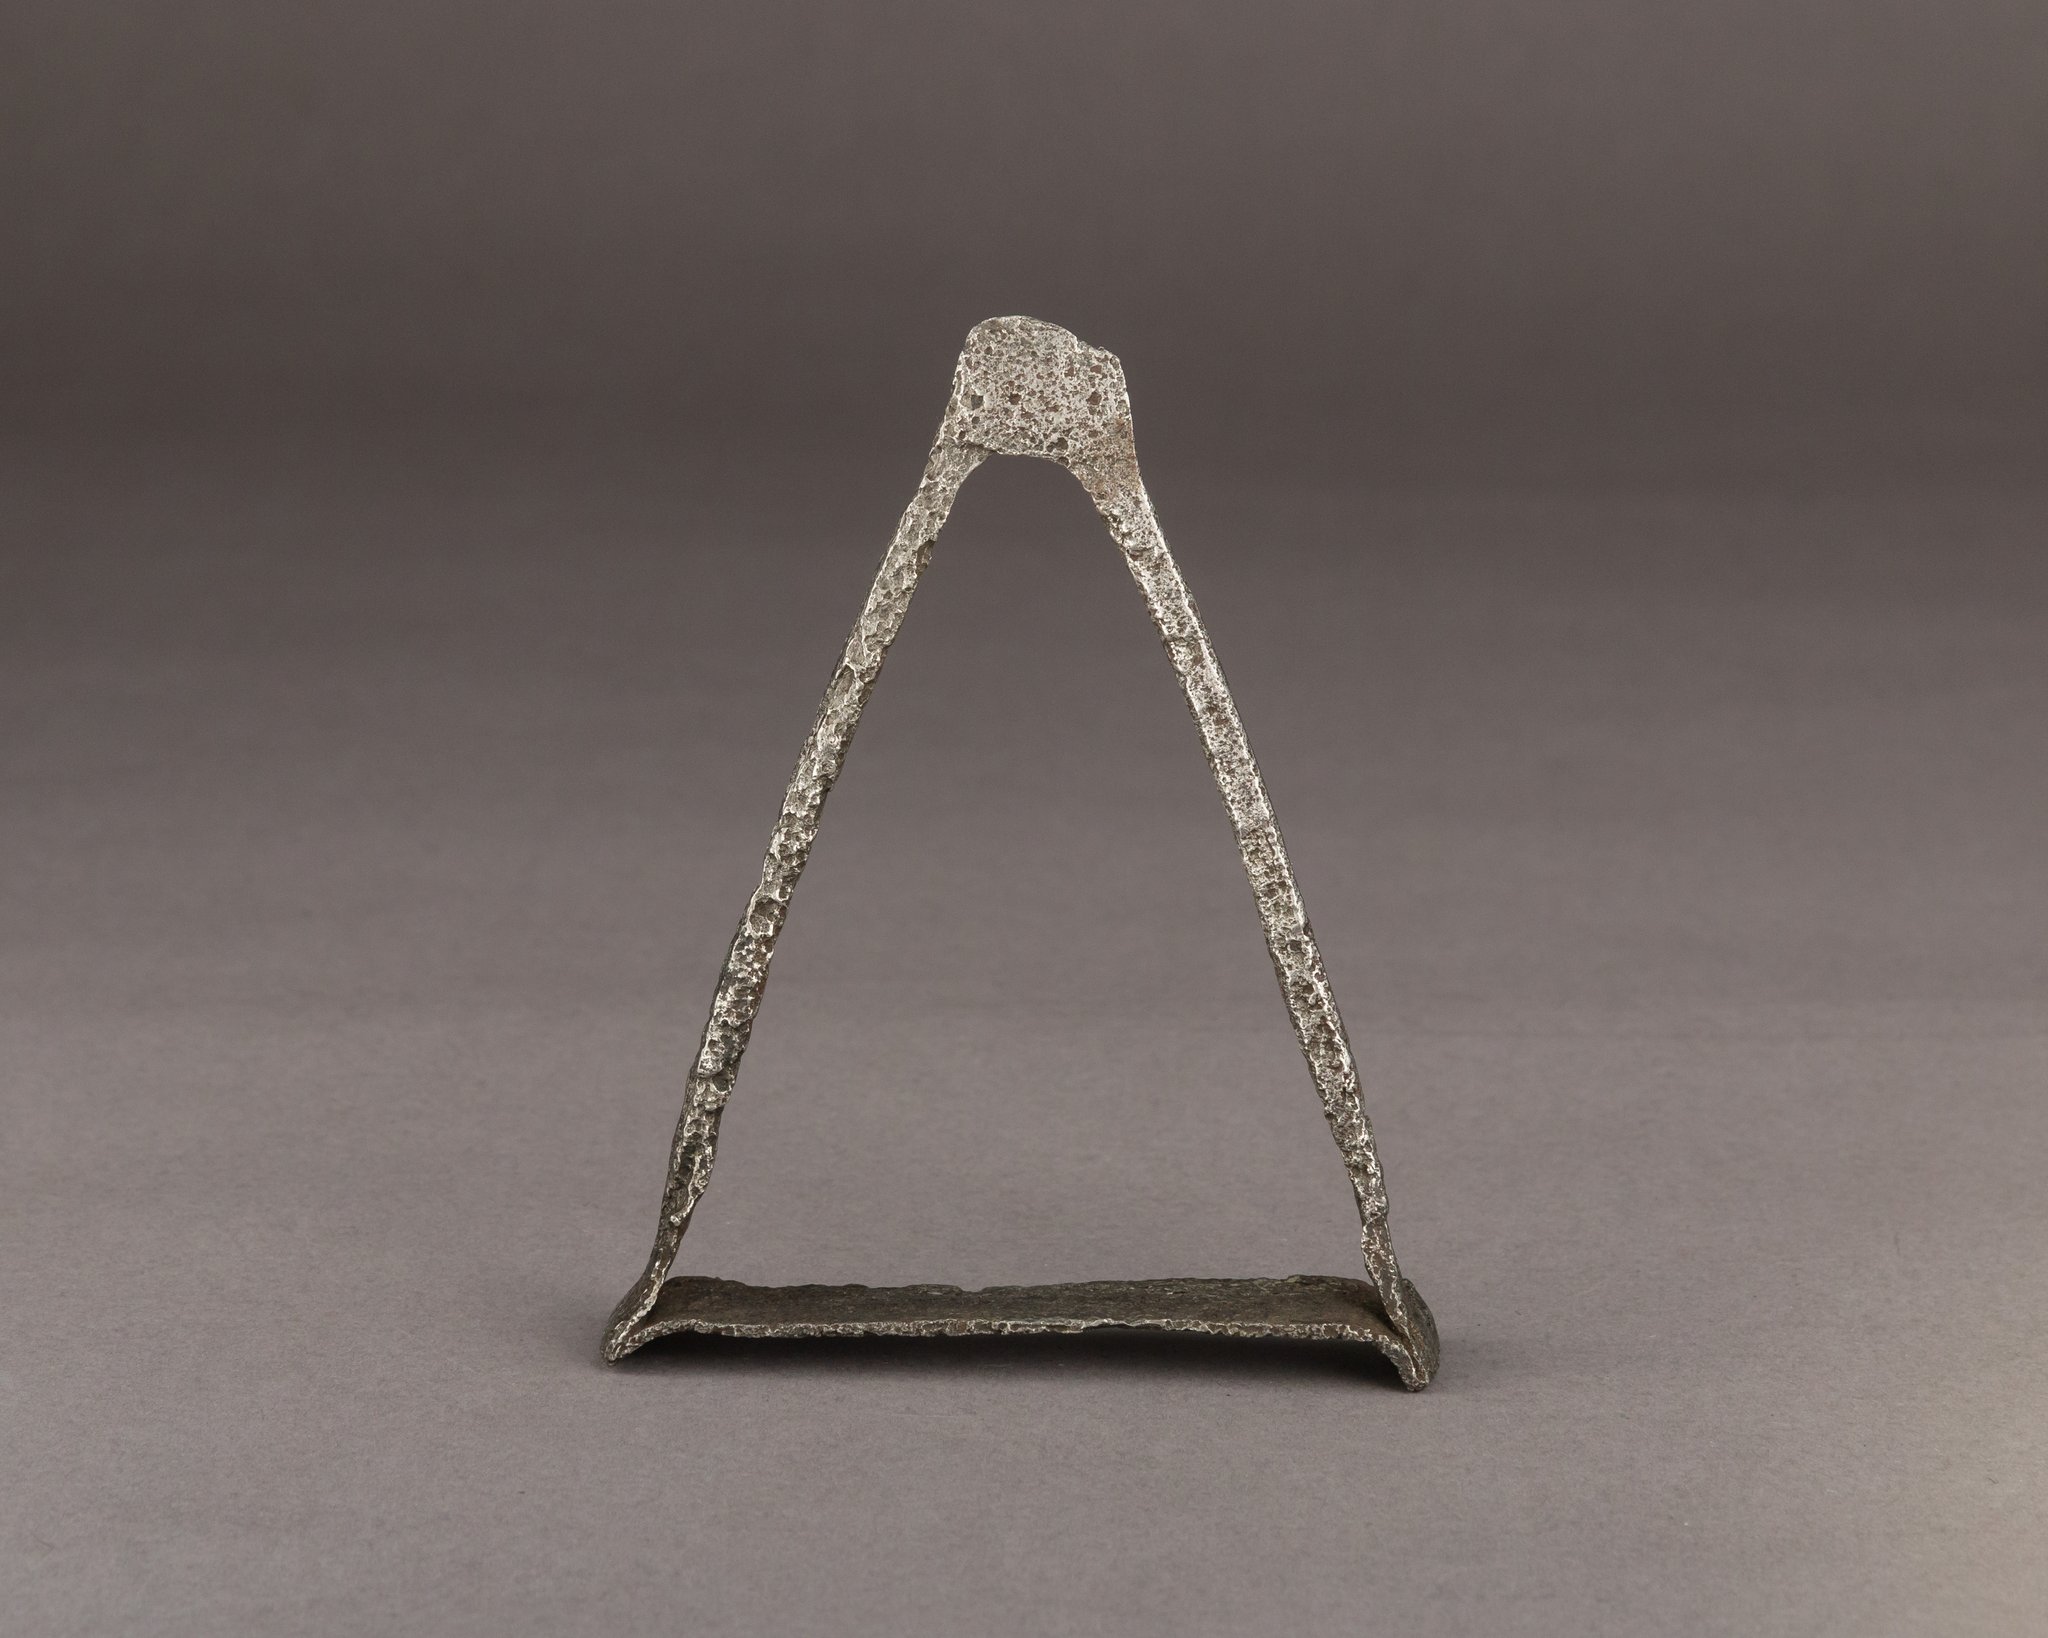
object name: stirrup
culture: german or west slavic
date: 901-1100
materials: iron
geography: poland